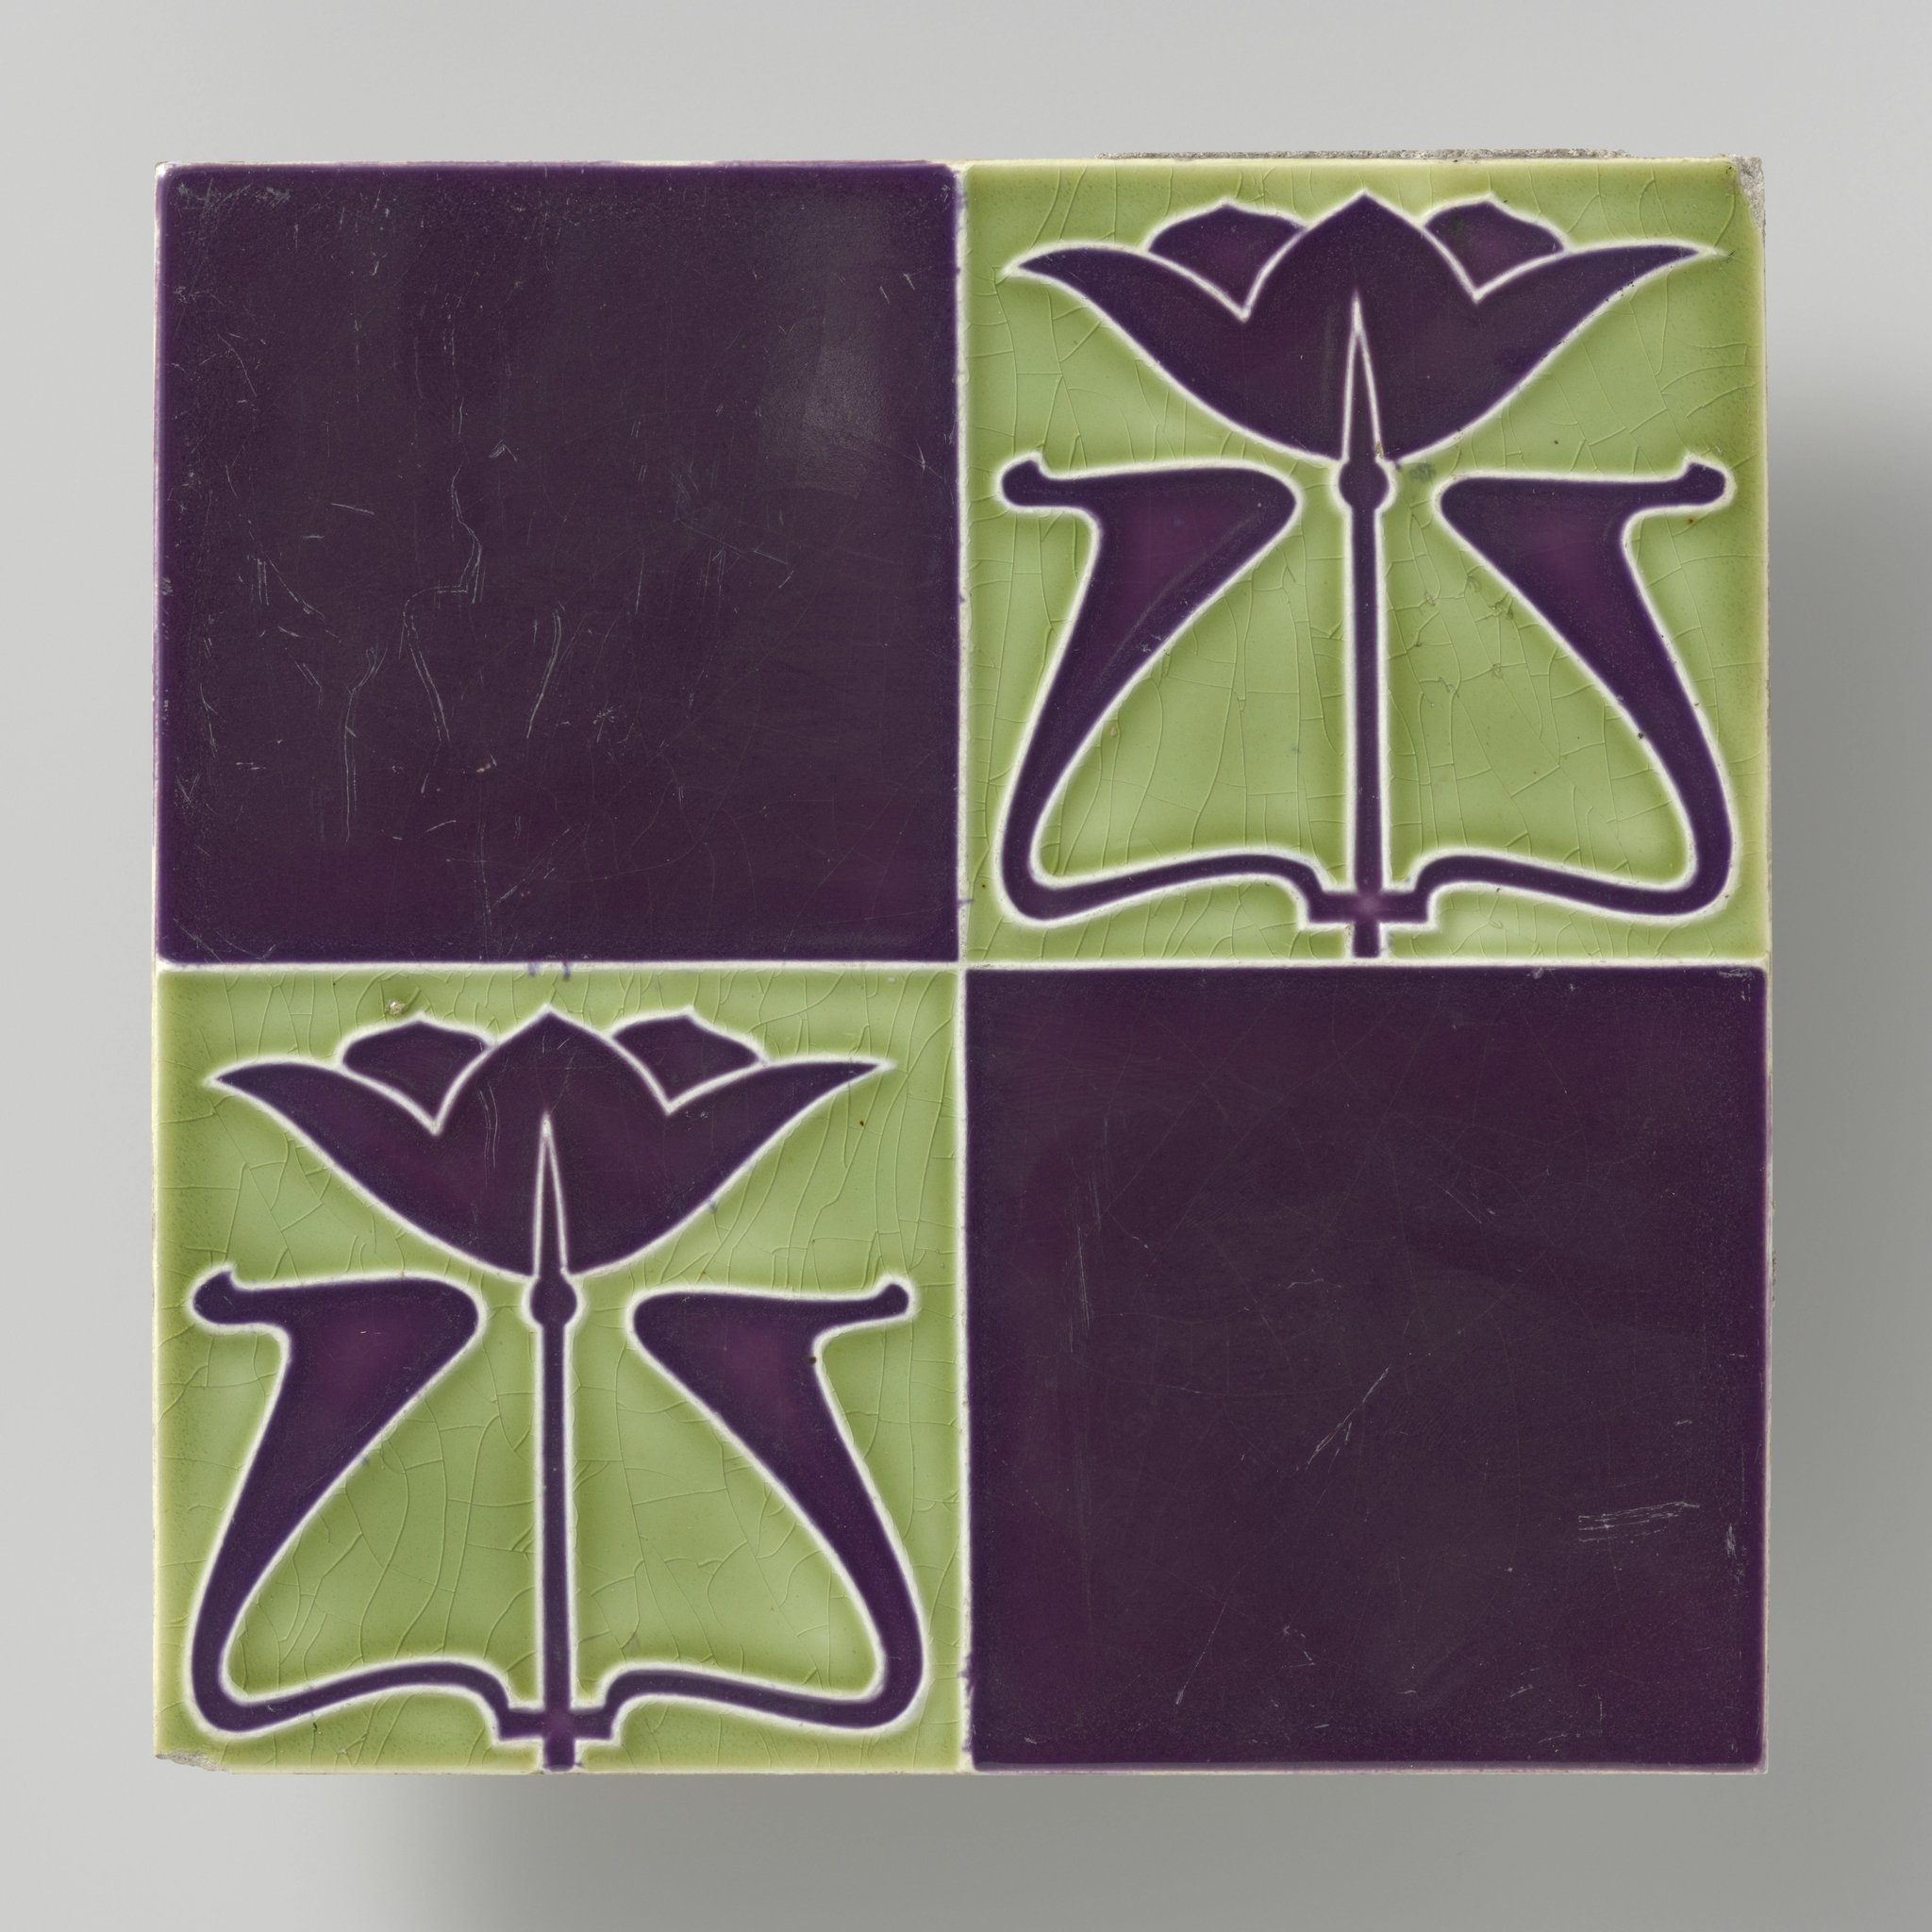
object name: tile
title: Tegel versierd in paars en groen met twee bloemkelken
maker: Anonymous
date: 1900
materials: stoneware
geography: netherlands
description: Tegel van steengoed, versierd in paars en groen met twee diagonaalsgewijs geplaatste gestileerde bloemkelken.